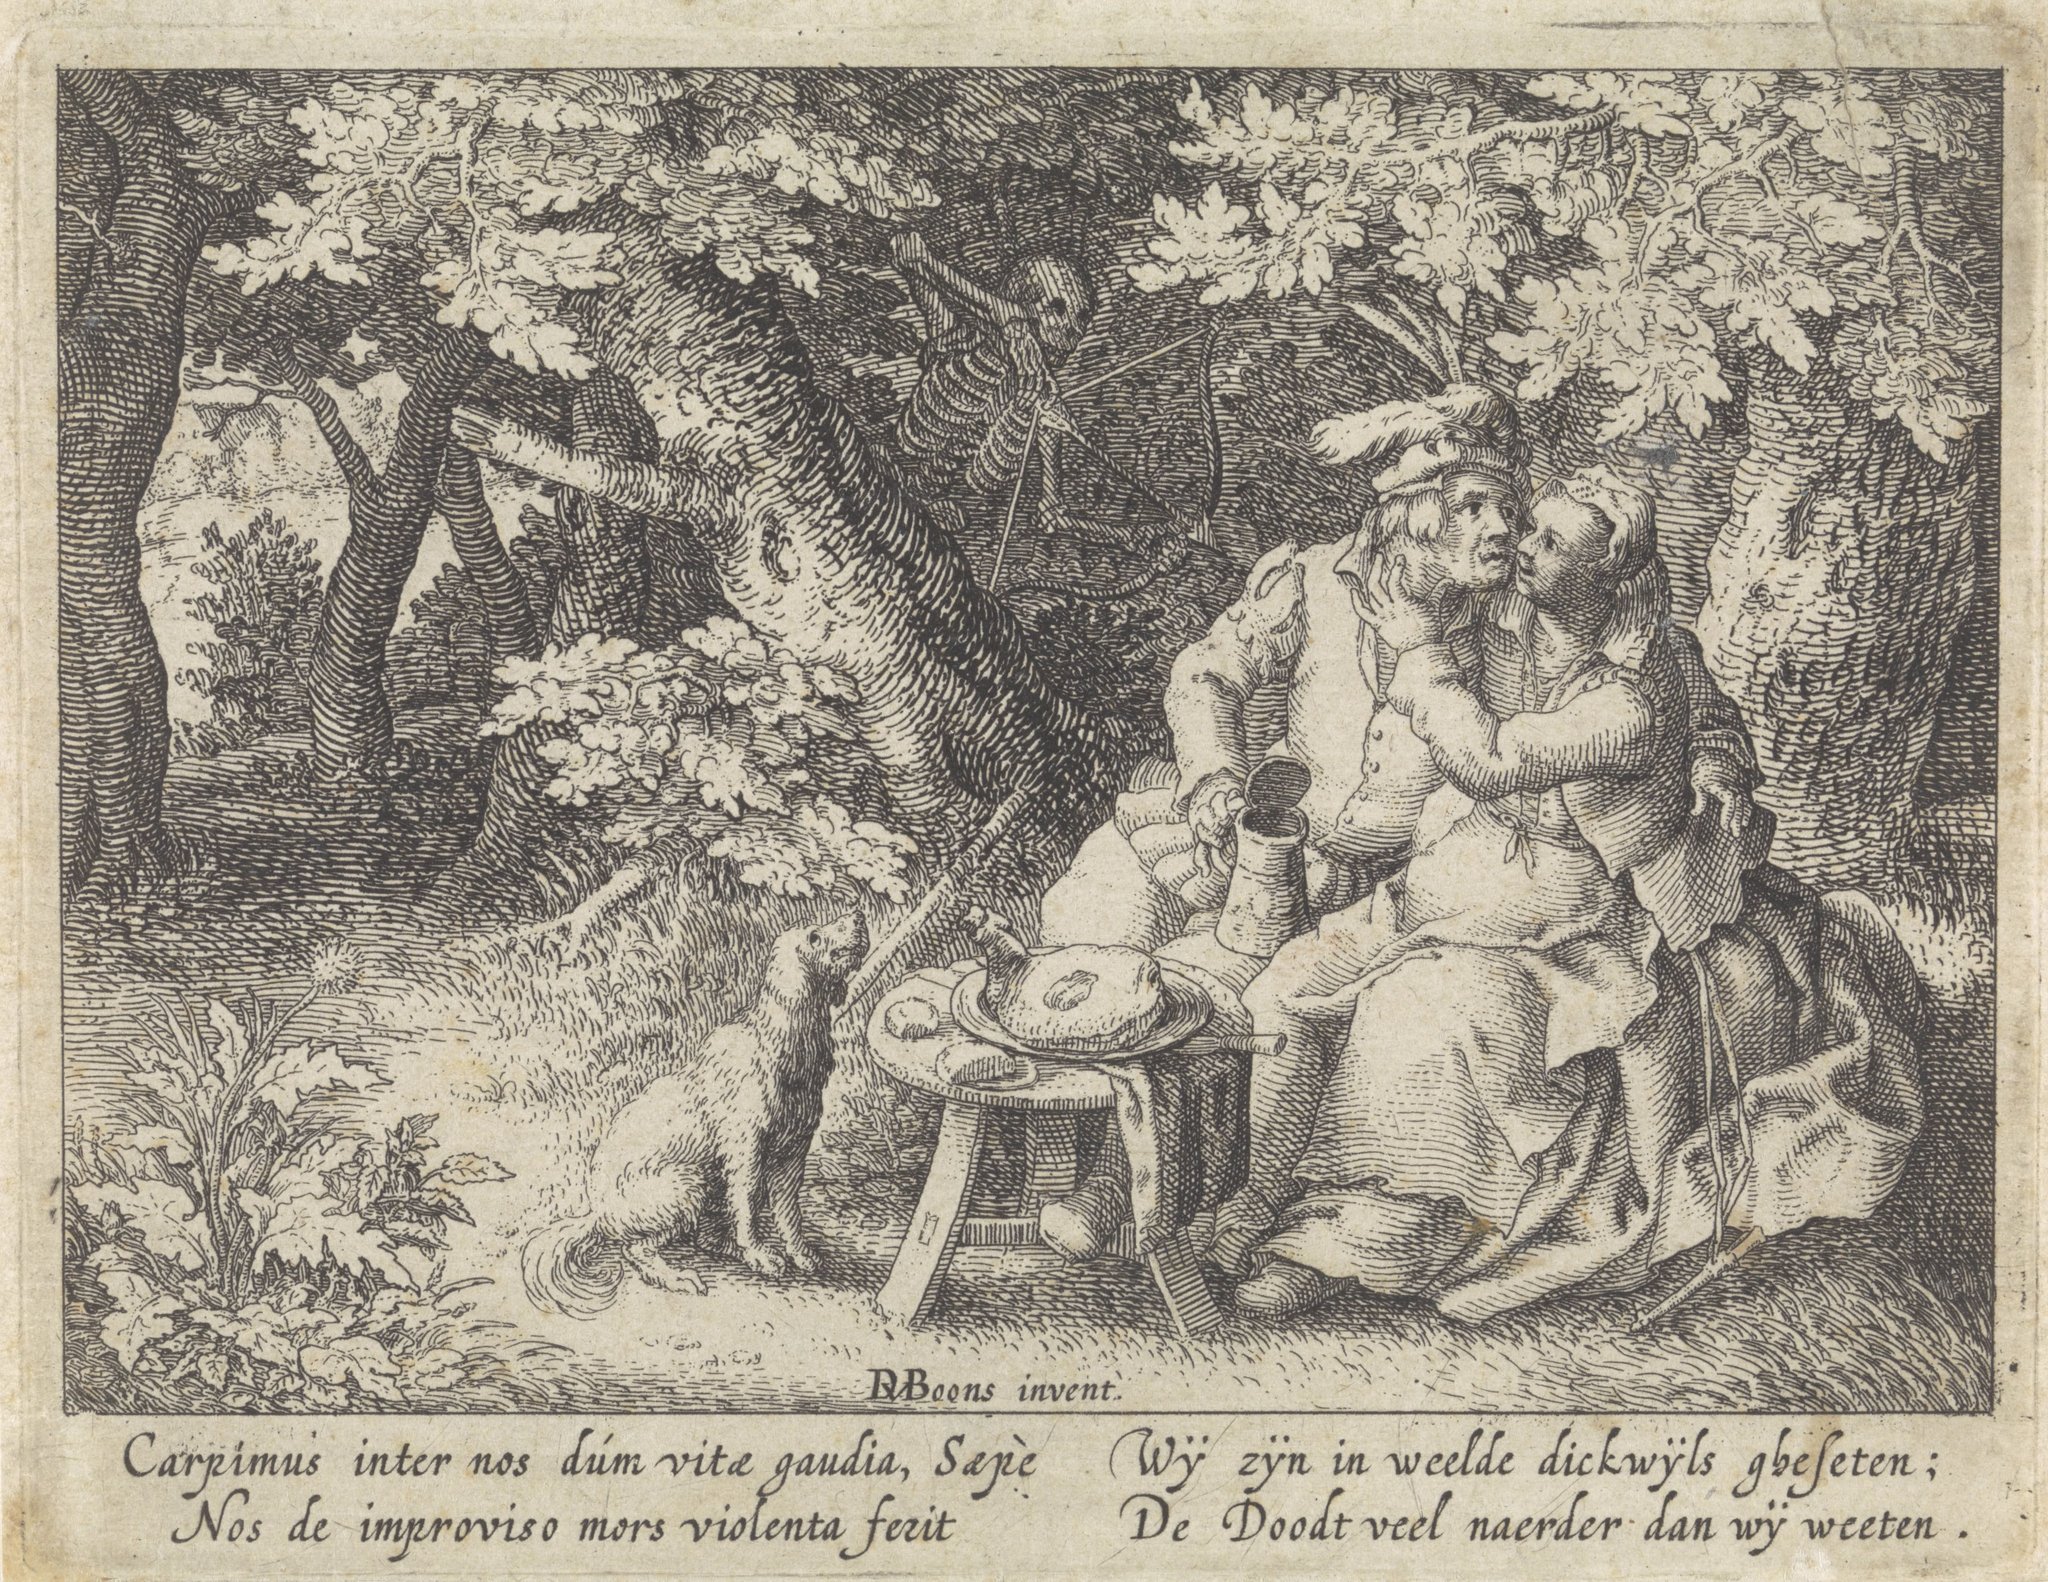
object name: print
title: Paar door de dood verrast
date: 1600-1650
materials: paper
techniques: etching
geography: northern netherlands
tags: death as skeleton, (lovers) caressing each other, (family) meal - cc - out of doors, ham, dog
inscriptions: collector's mark: Lugt 2227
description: Een verliefd paar wordt in een bos verrast door de Dood, die, in de gedaante van een geraamte, zijn pijl op hen richt. Voor het paar een tafel met een bout. Bij de tafel een hond.